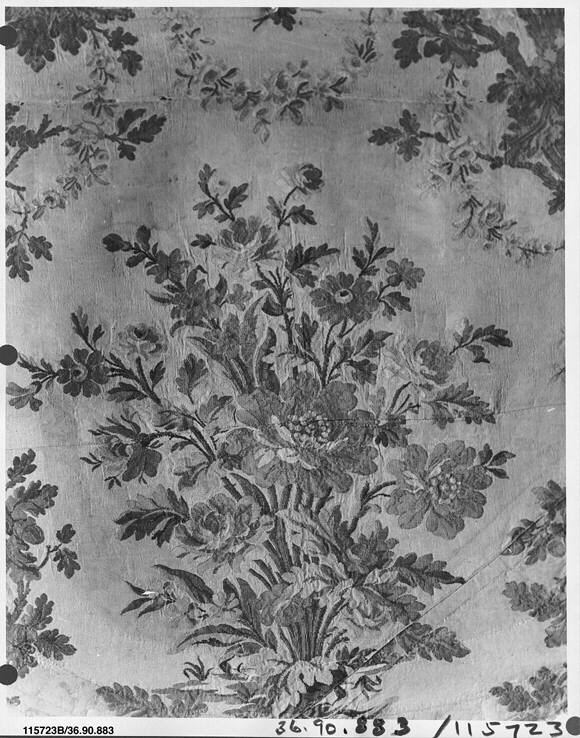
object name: piece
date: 1750-1760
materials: silk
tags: flowers,leaves